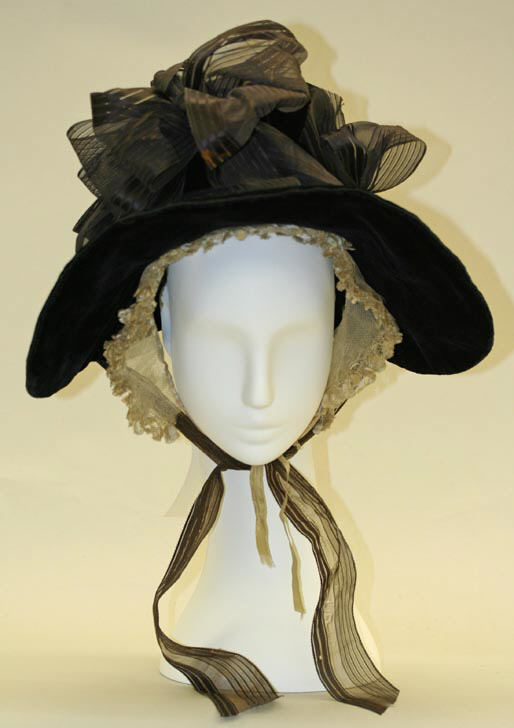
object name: poke bonnet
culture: american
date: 1835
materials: silk